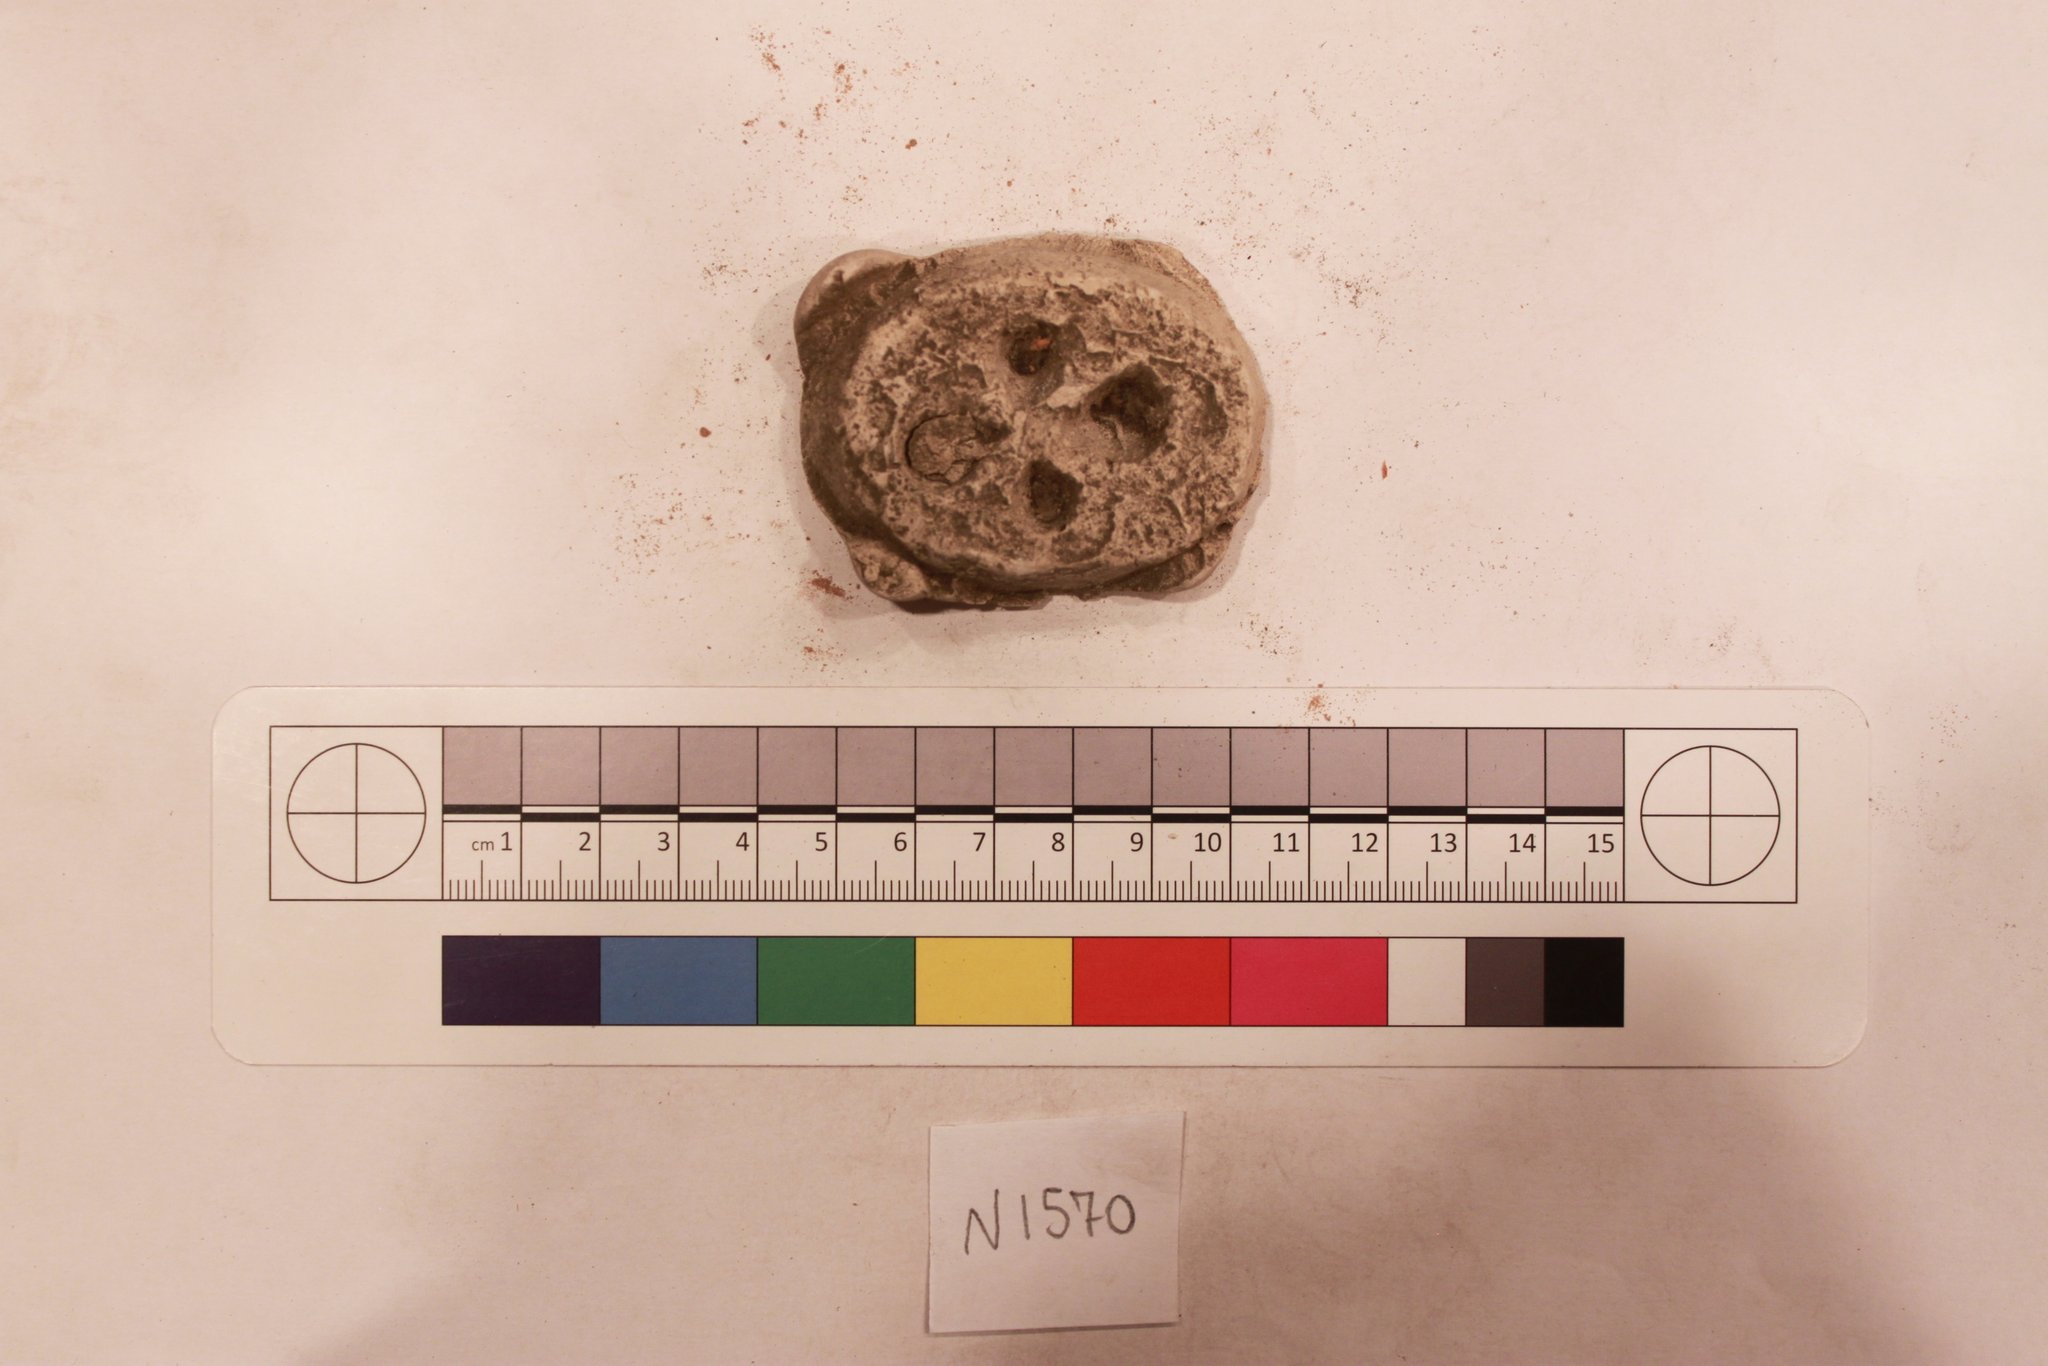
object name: fragment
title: Stucco Fragment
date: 701-1200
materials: plaster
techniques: carving, painting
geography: iran